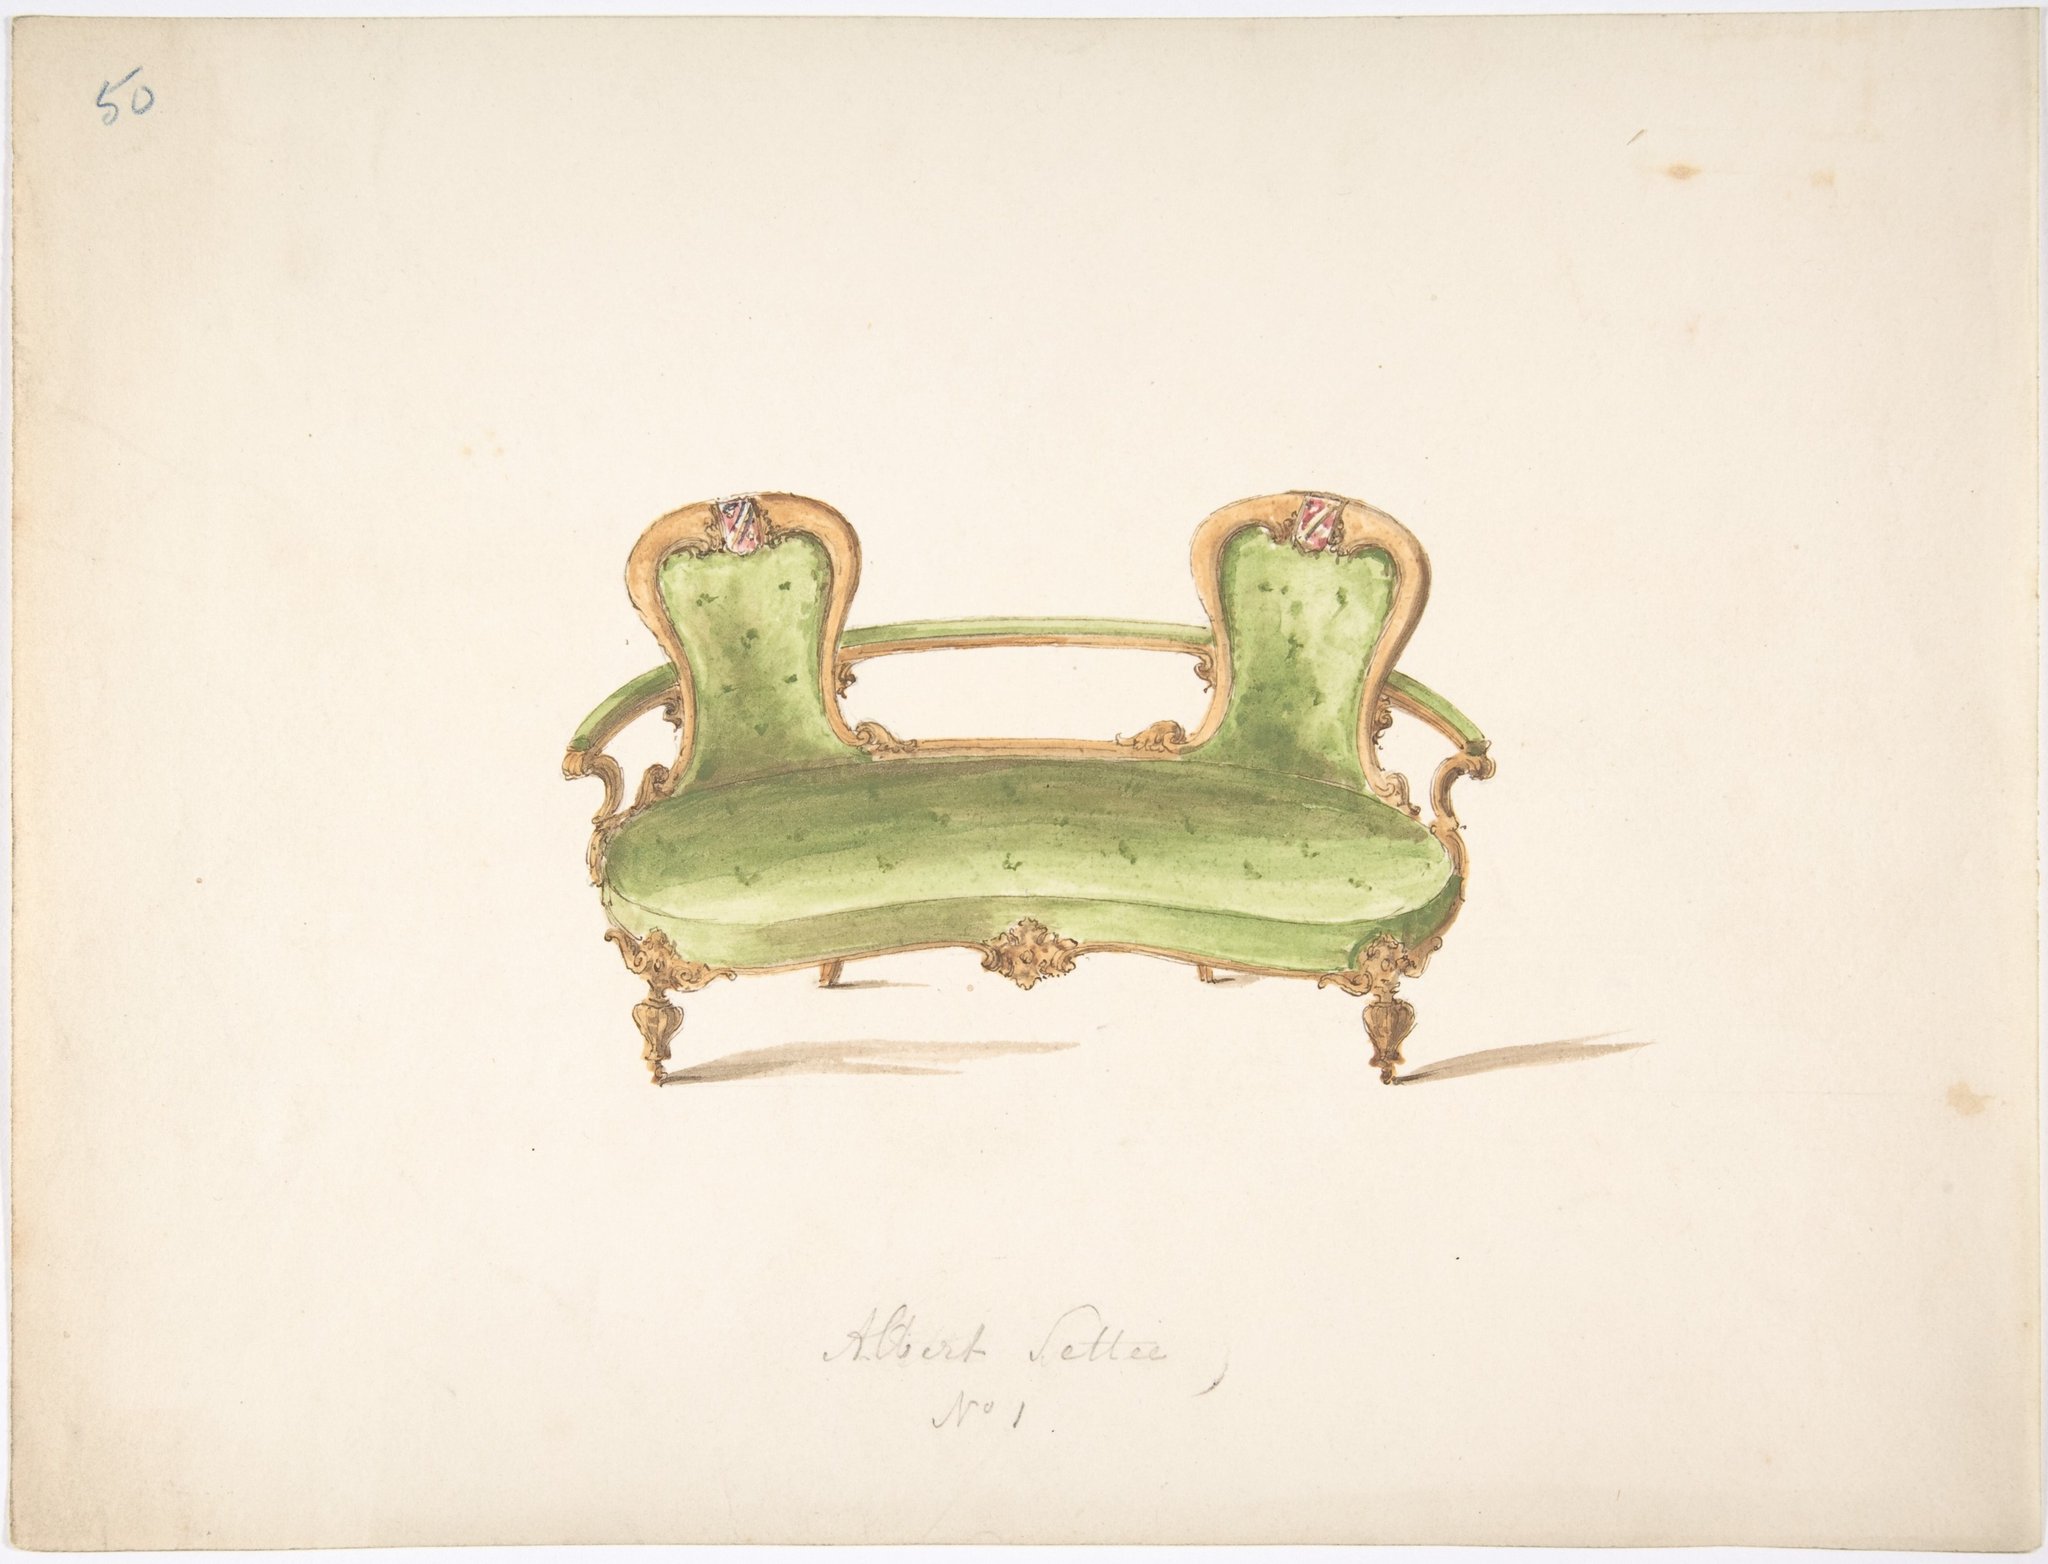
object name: drawing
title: Design for Albert Settee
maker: anonymous, british, 19th century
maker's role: artist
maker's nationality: british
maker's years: 1800-1900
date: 1801-1833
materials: ink, watercolor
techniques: brush, pen, wash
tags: couches